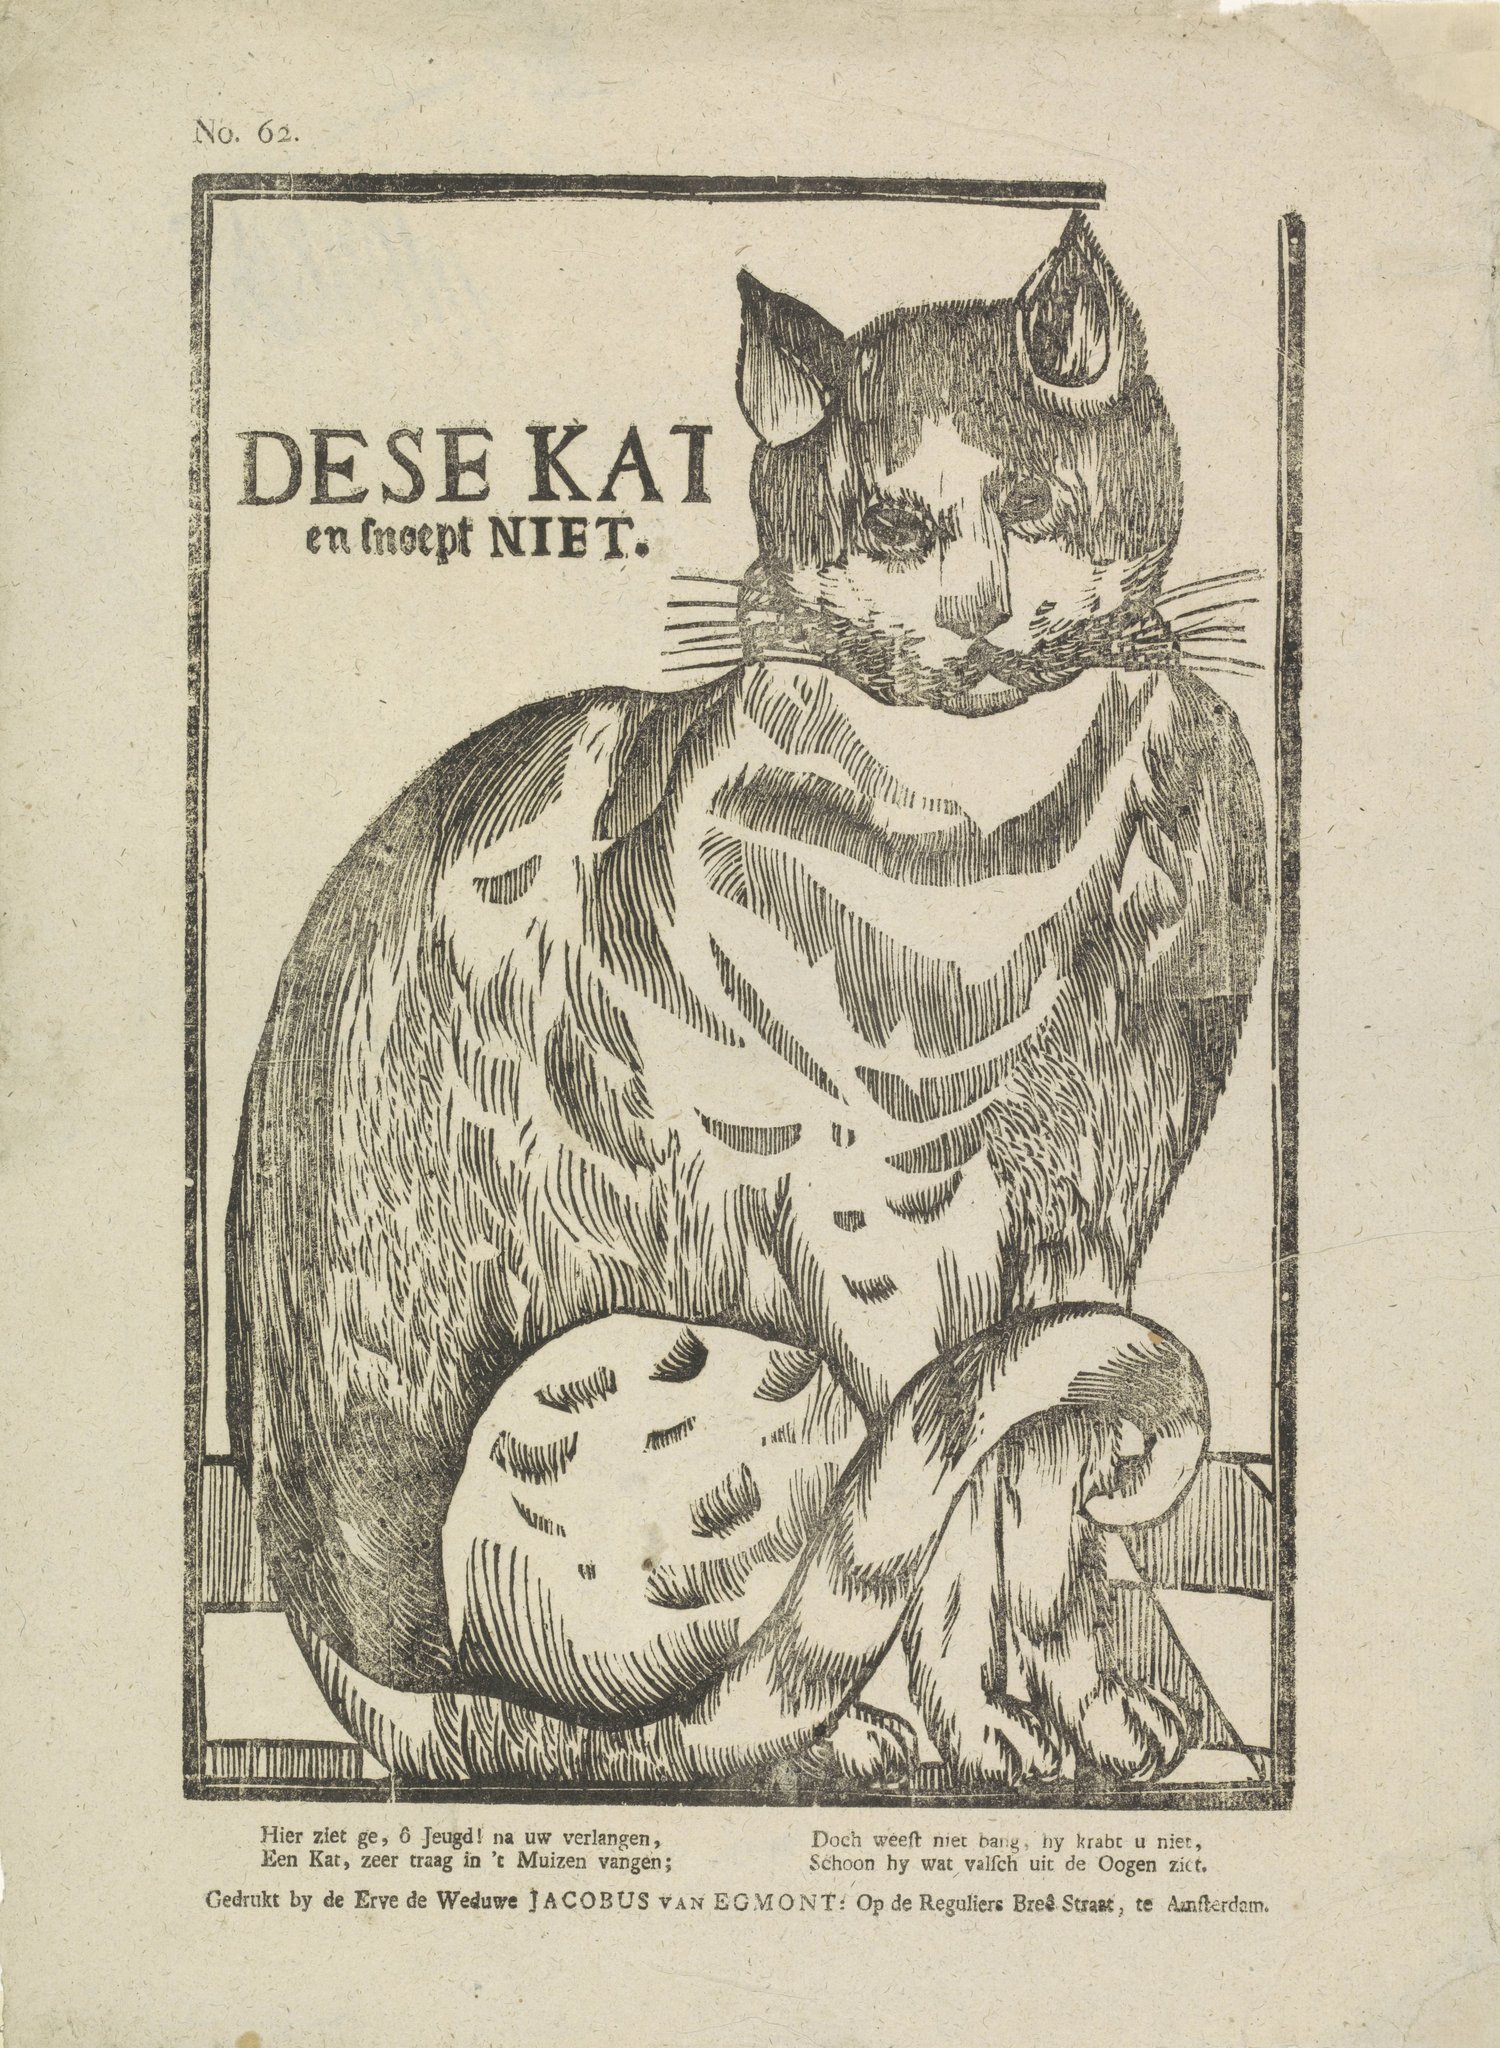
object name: popular print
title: Dese kat / en snoept niet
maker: Anonymous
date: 1761-1804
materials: paper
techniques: letterpress printing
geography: amsterdam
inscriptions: collector's mark: Lugt 2760, collector's mark: Lugt 2228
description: Een kat. Onder de voorstelling een vierregelig vers in twee kolommen. Genummerd linksboven: No. 60.